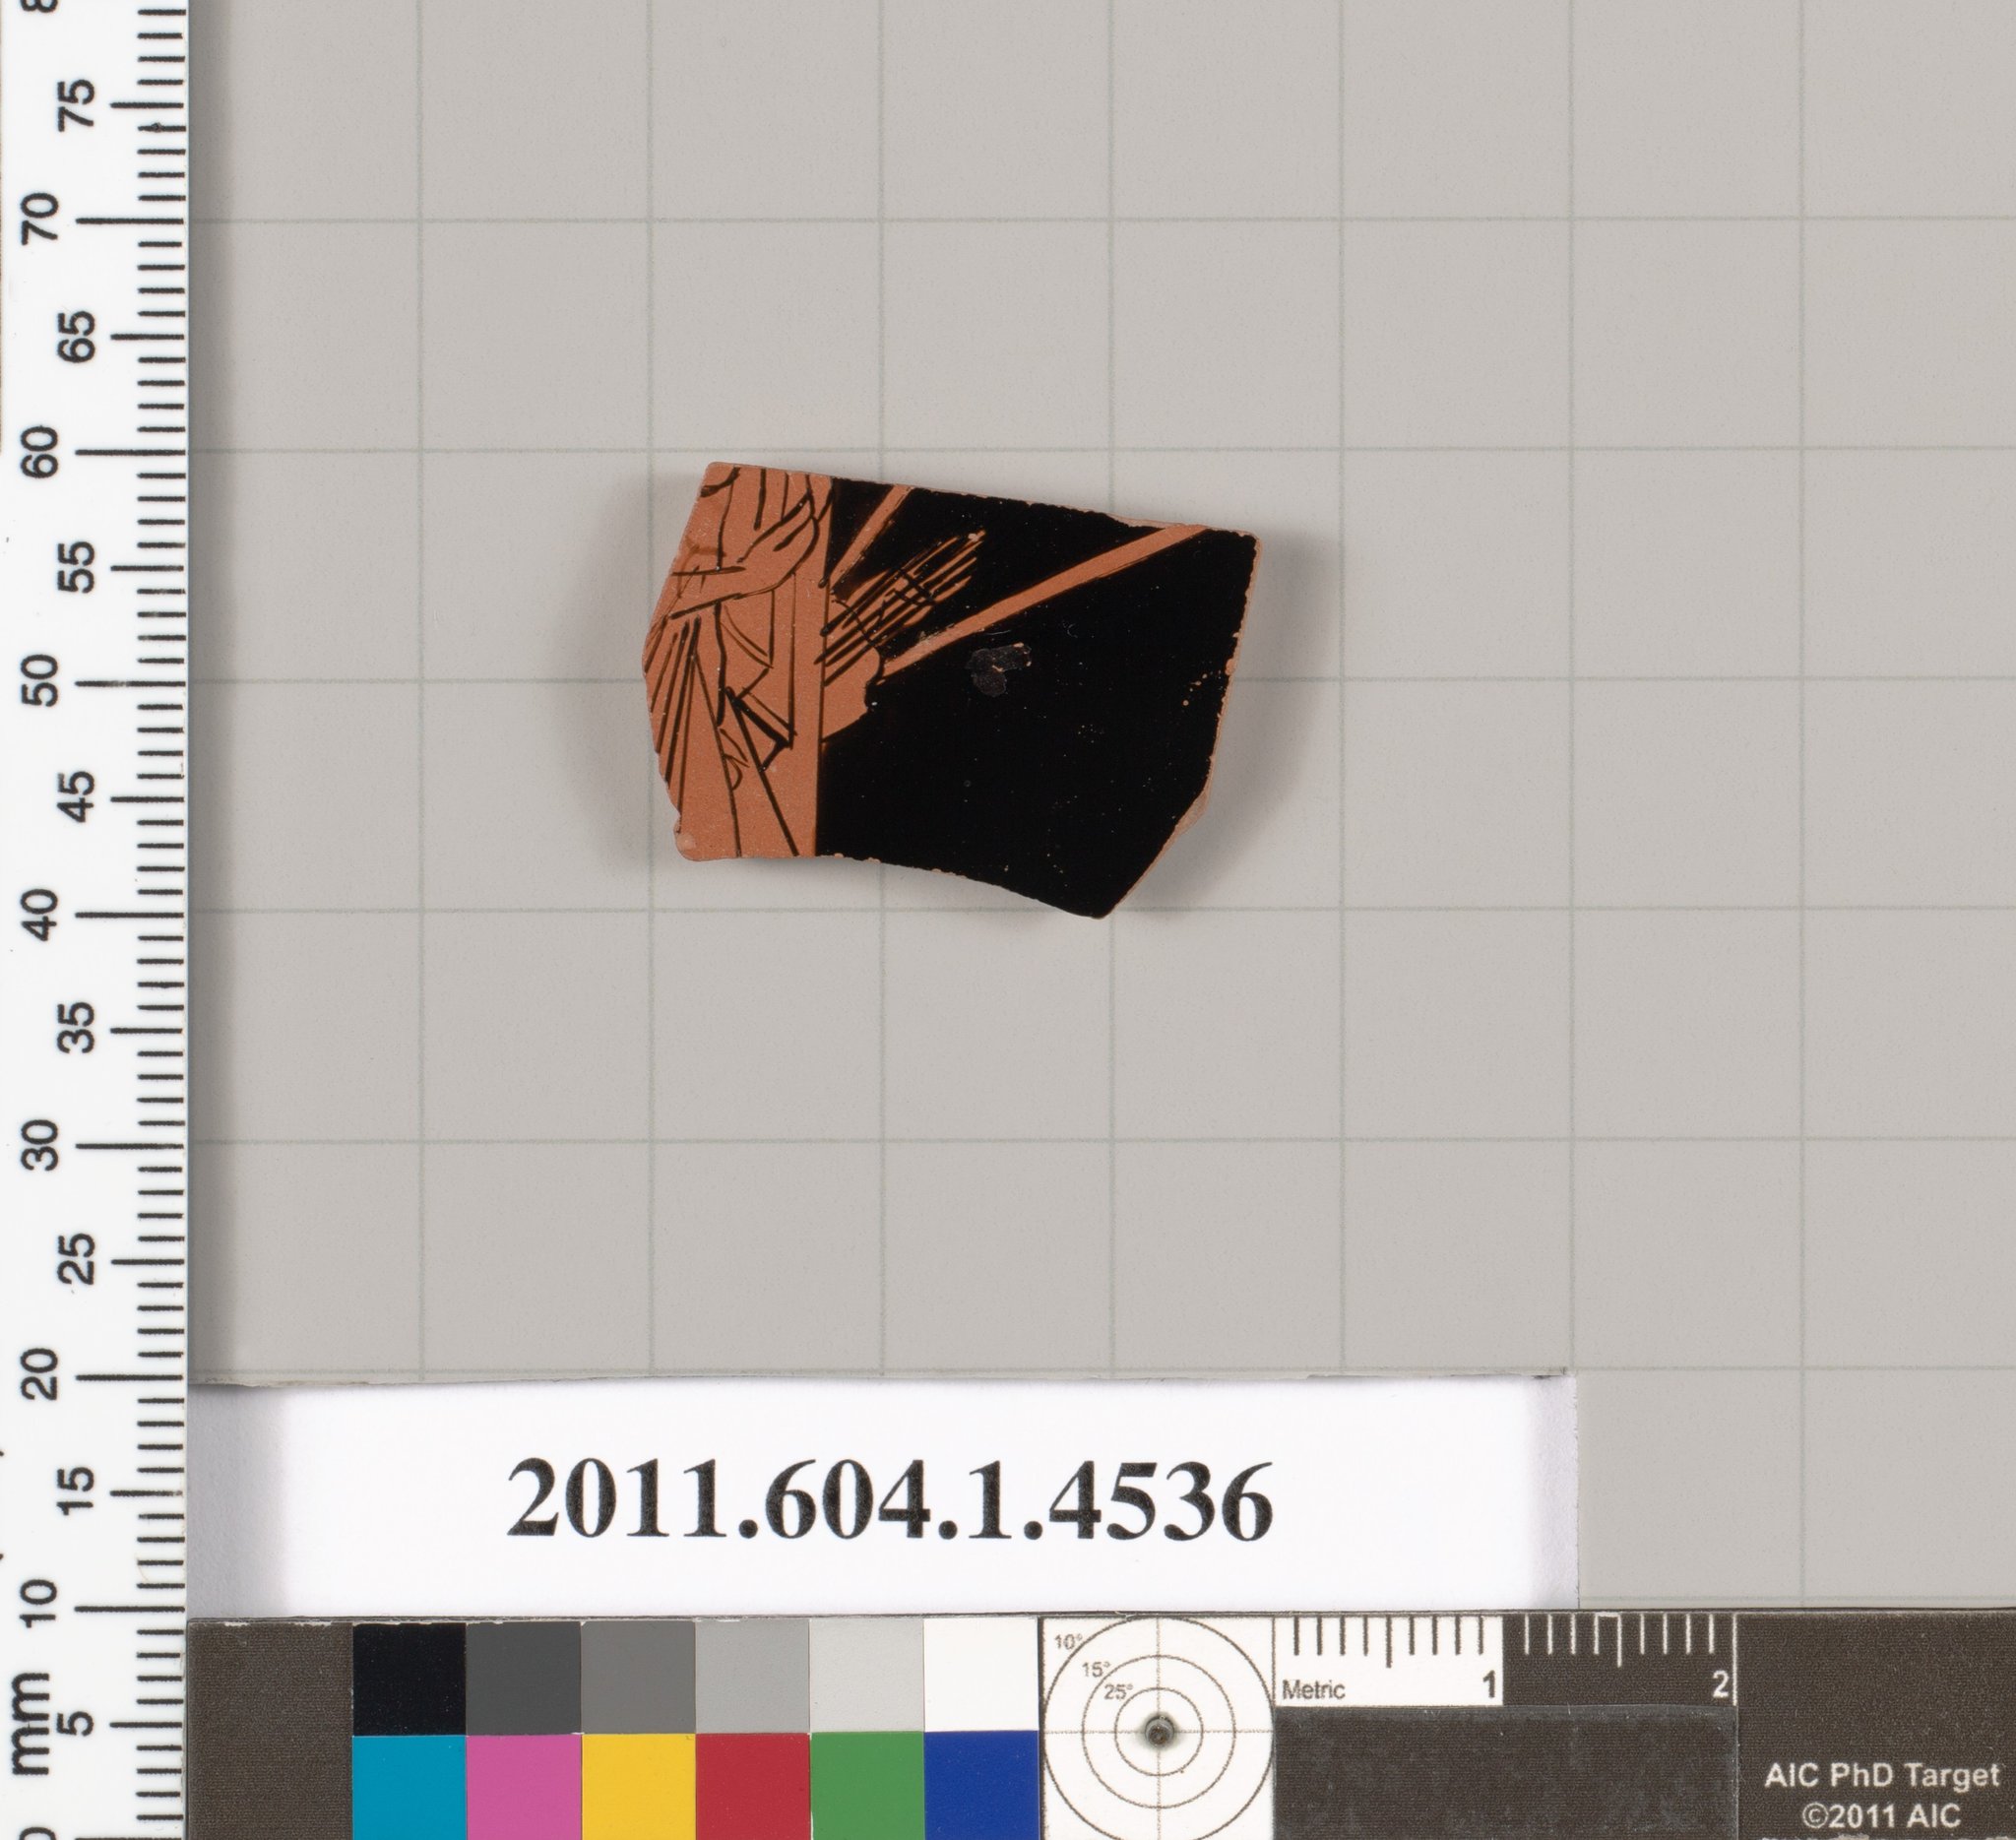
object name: kylix fragment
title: Terracotta fragment of a kylix (drinking cup)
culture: greek, attic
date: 500-480 BCE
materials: terracotta